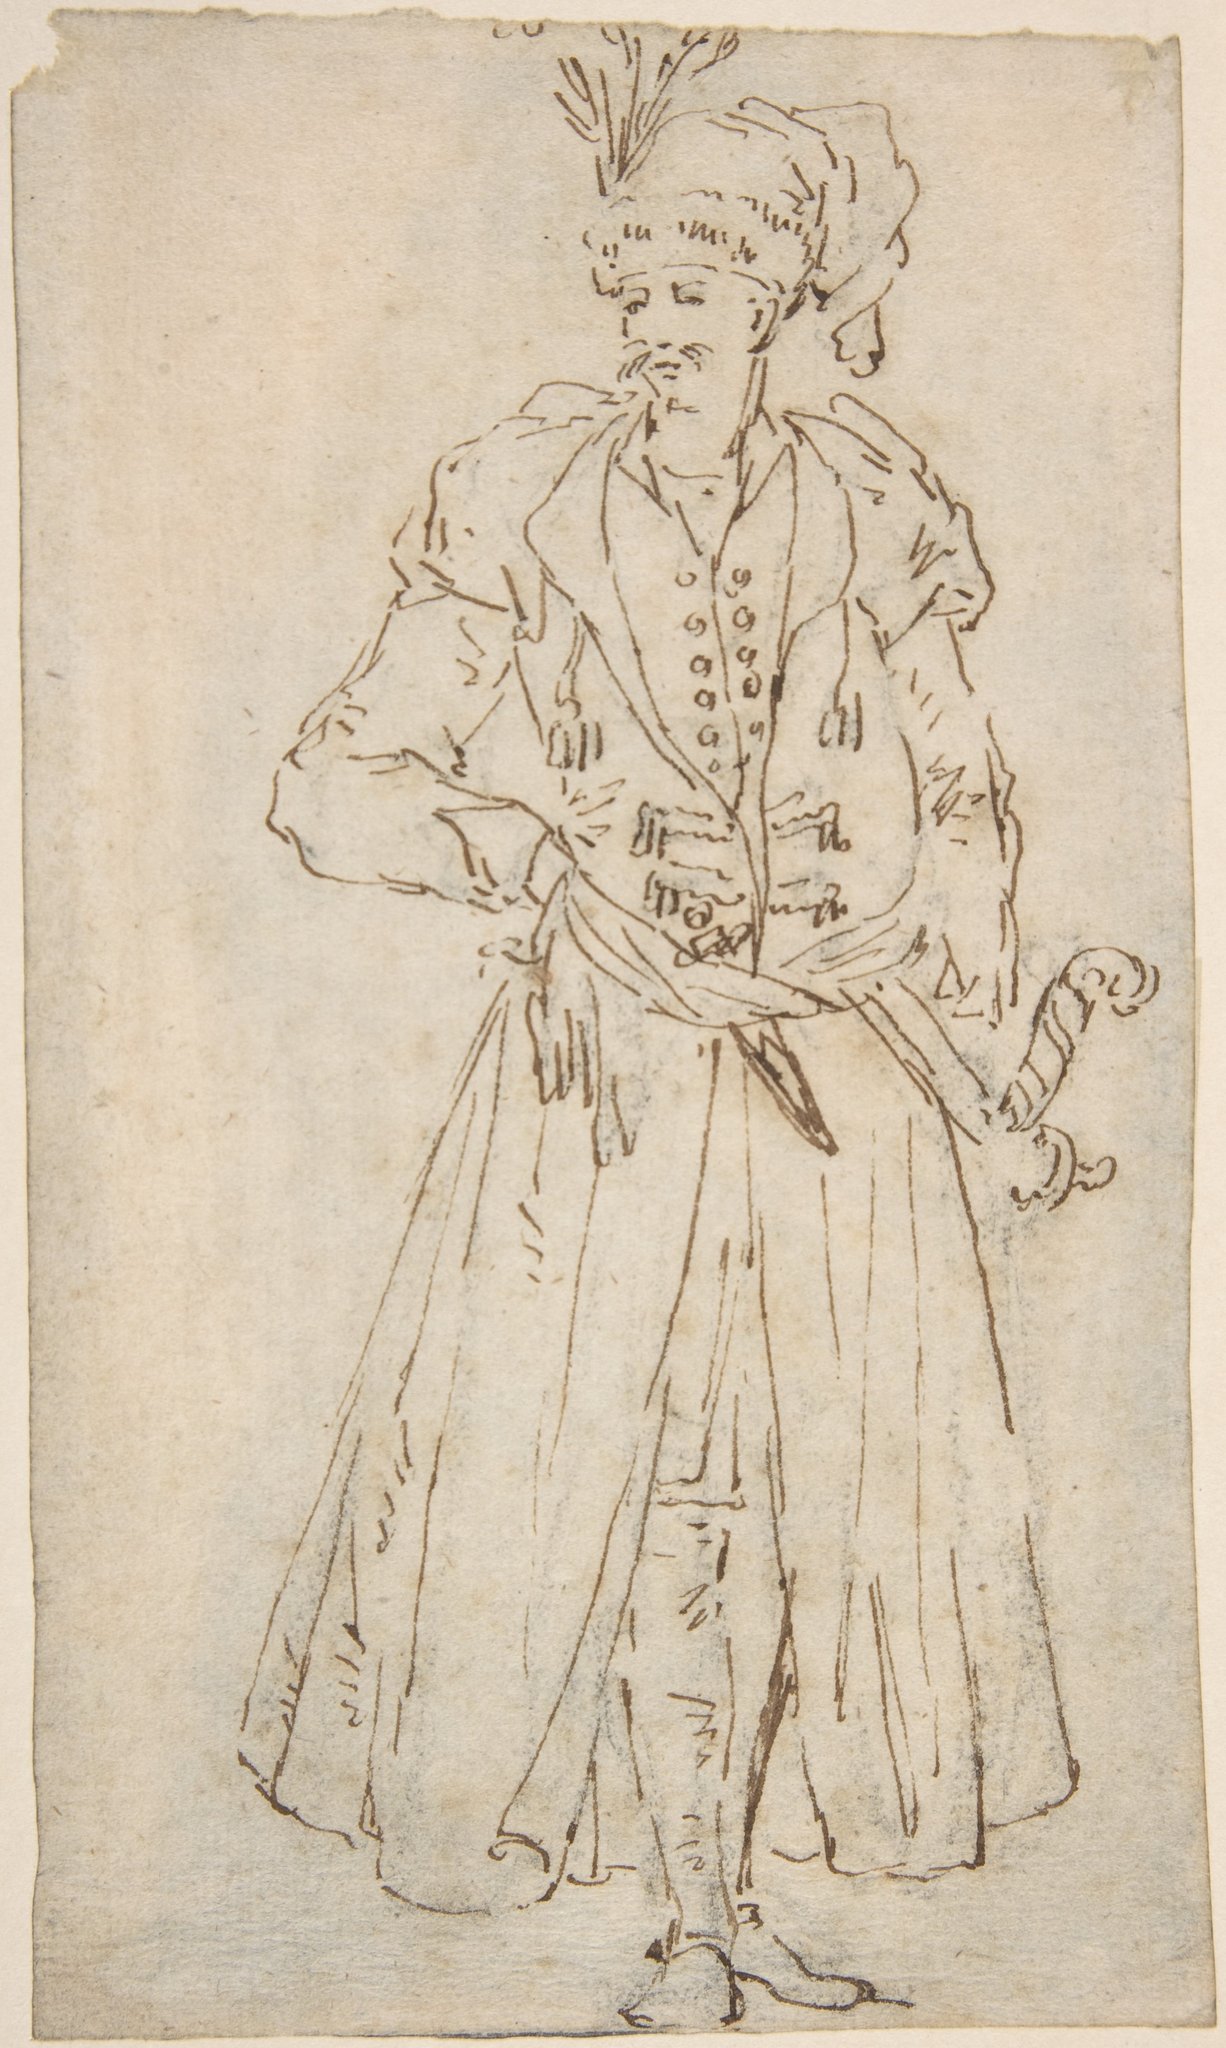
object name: drawing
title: Man in a Long Coat and Turban with a Sword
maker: anonymous, italian, 18th century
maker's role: artist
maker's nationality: italian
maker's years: 1700-1800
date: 1701-1800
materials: chalk, charcoal, ink, paper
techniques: incising, pen, transfer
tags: men